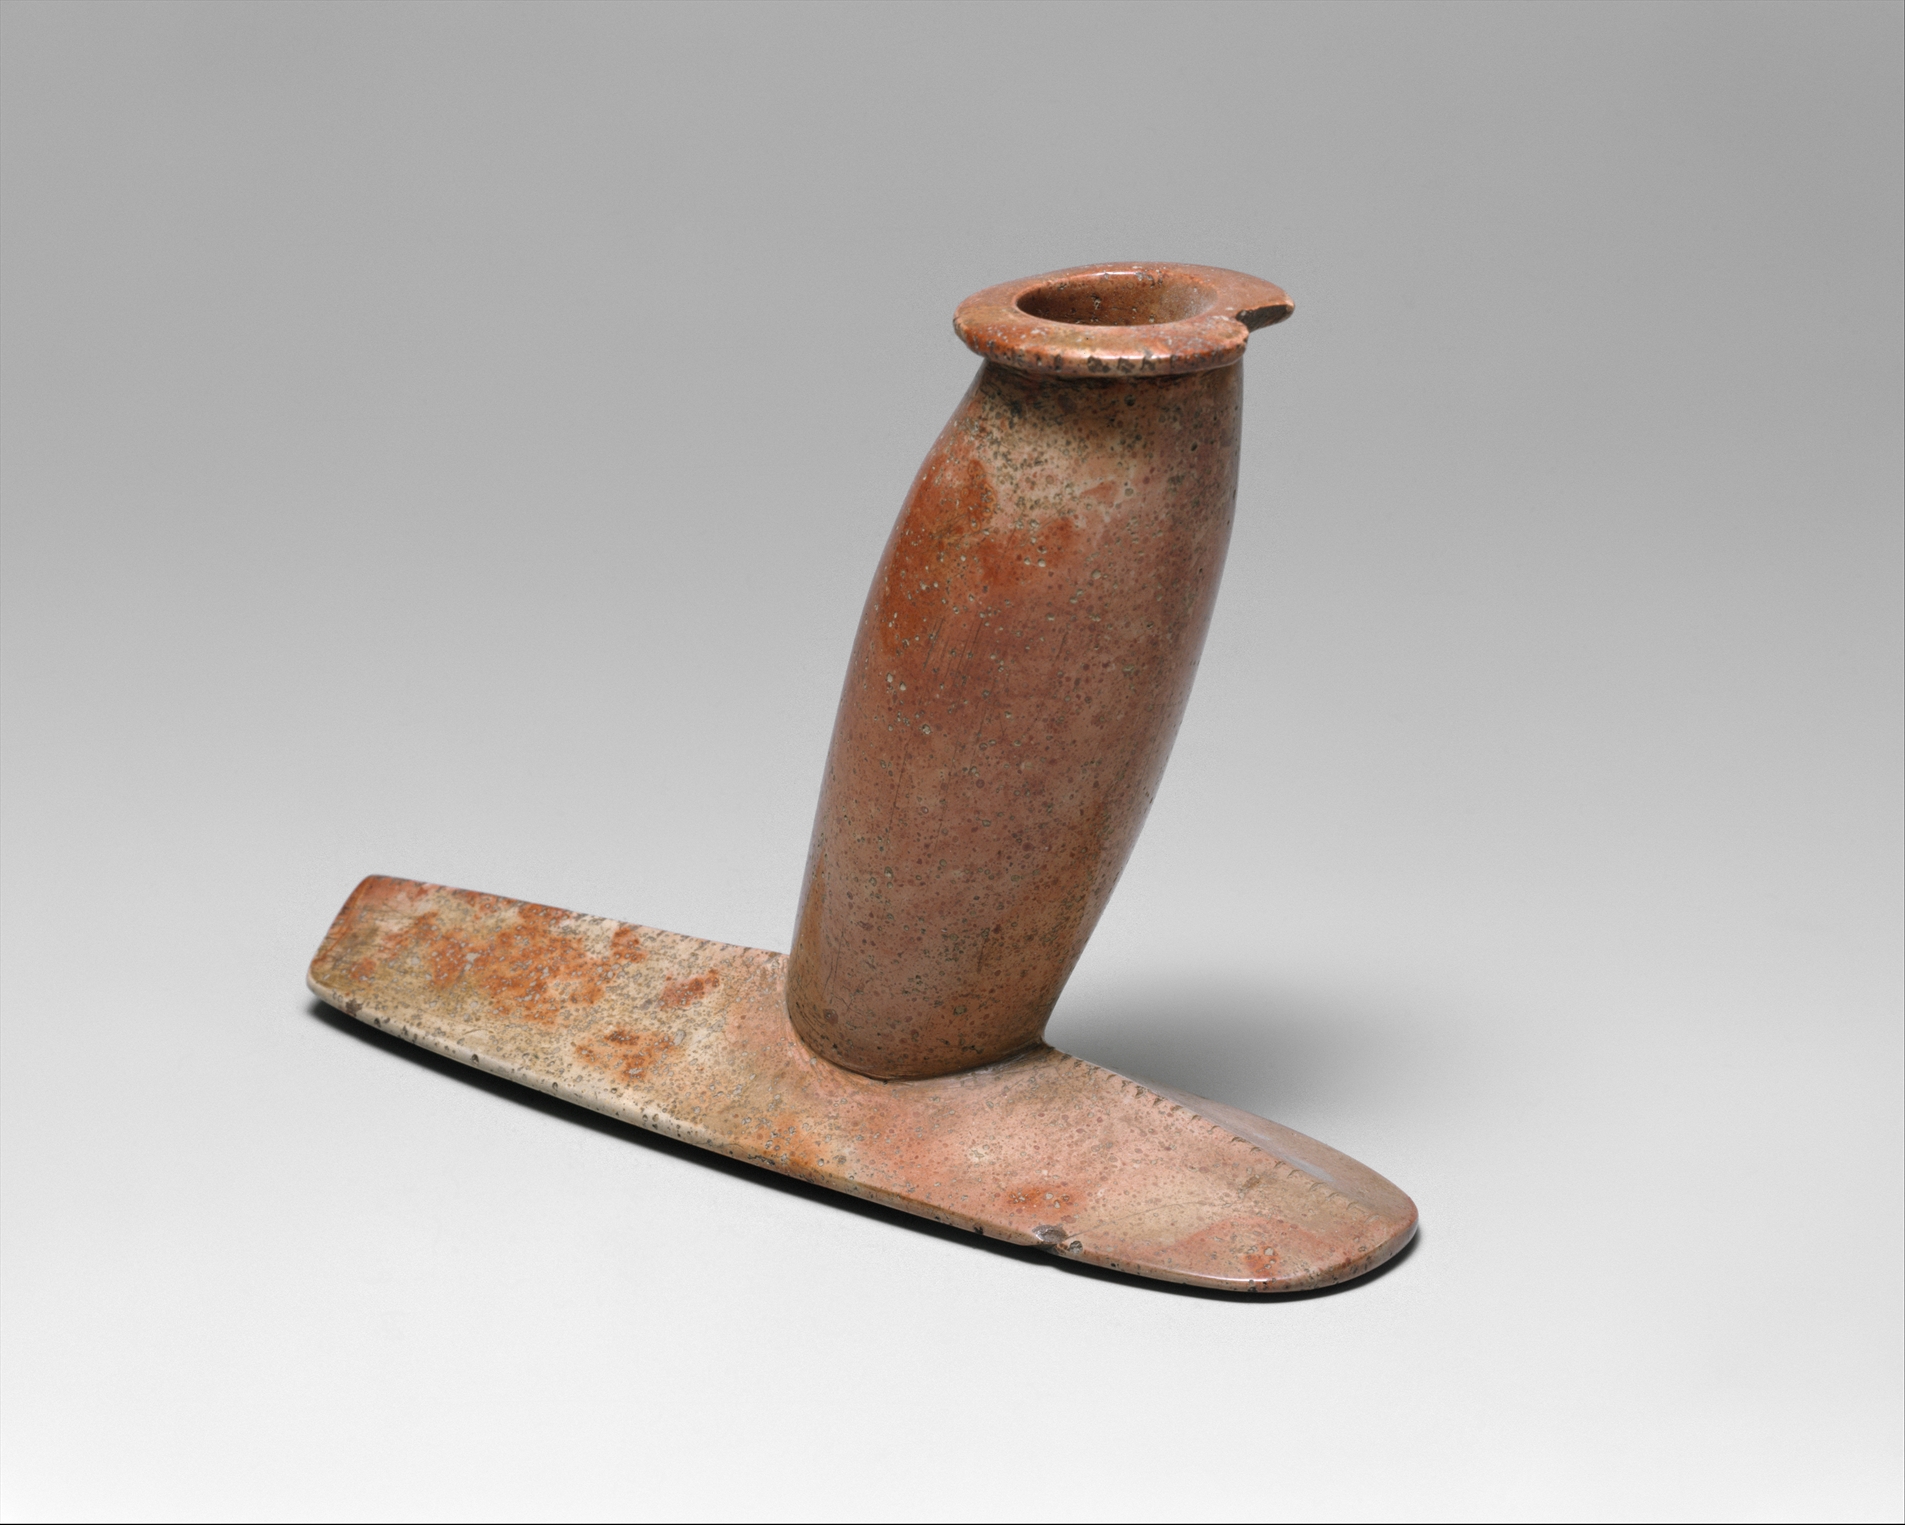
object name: pipe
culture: hopewellian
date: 100 BCE-400 CE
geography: united states